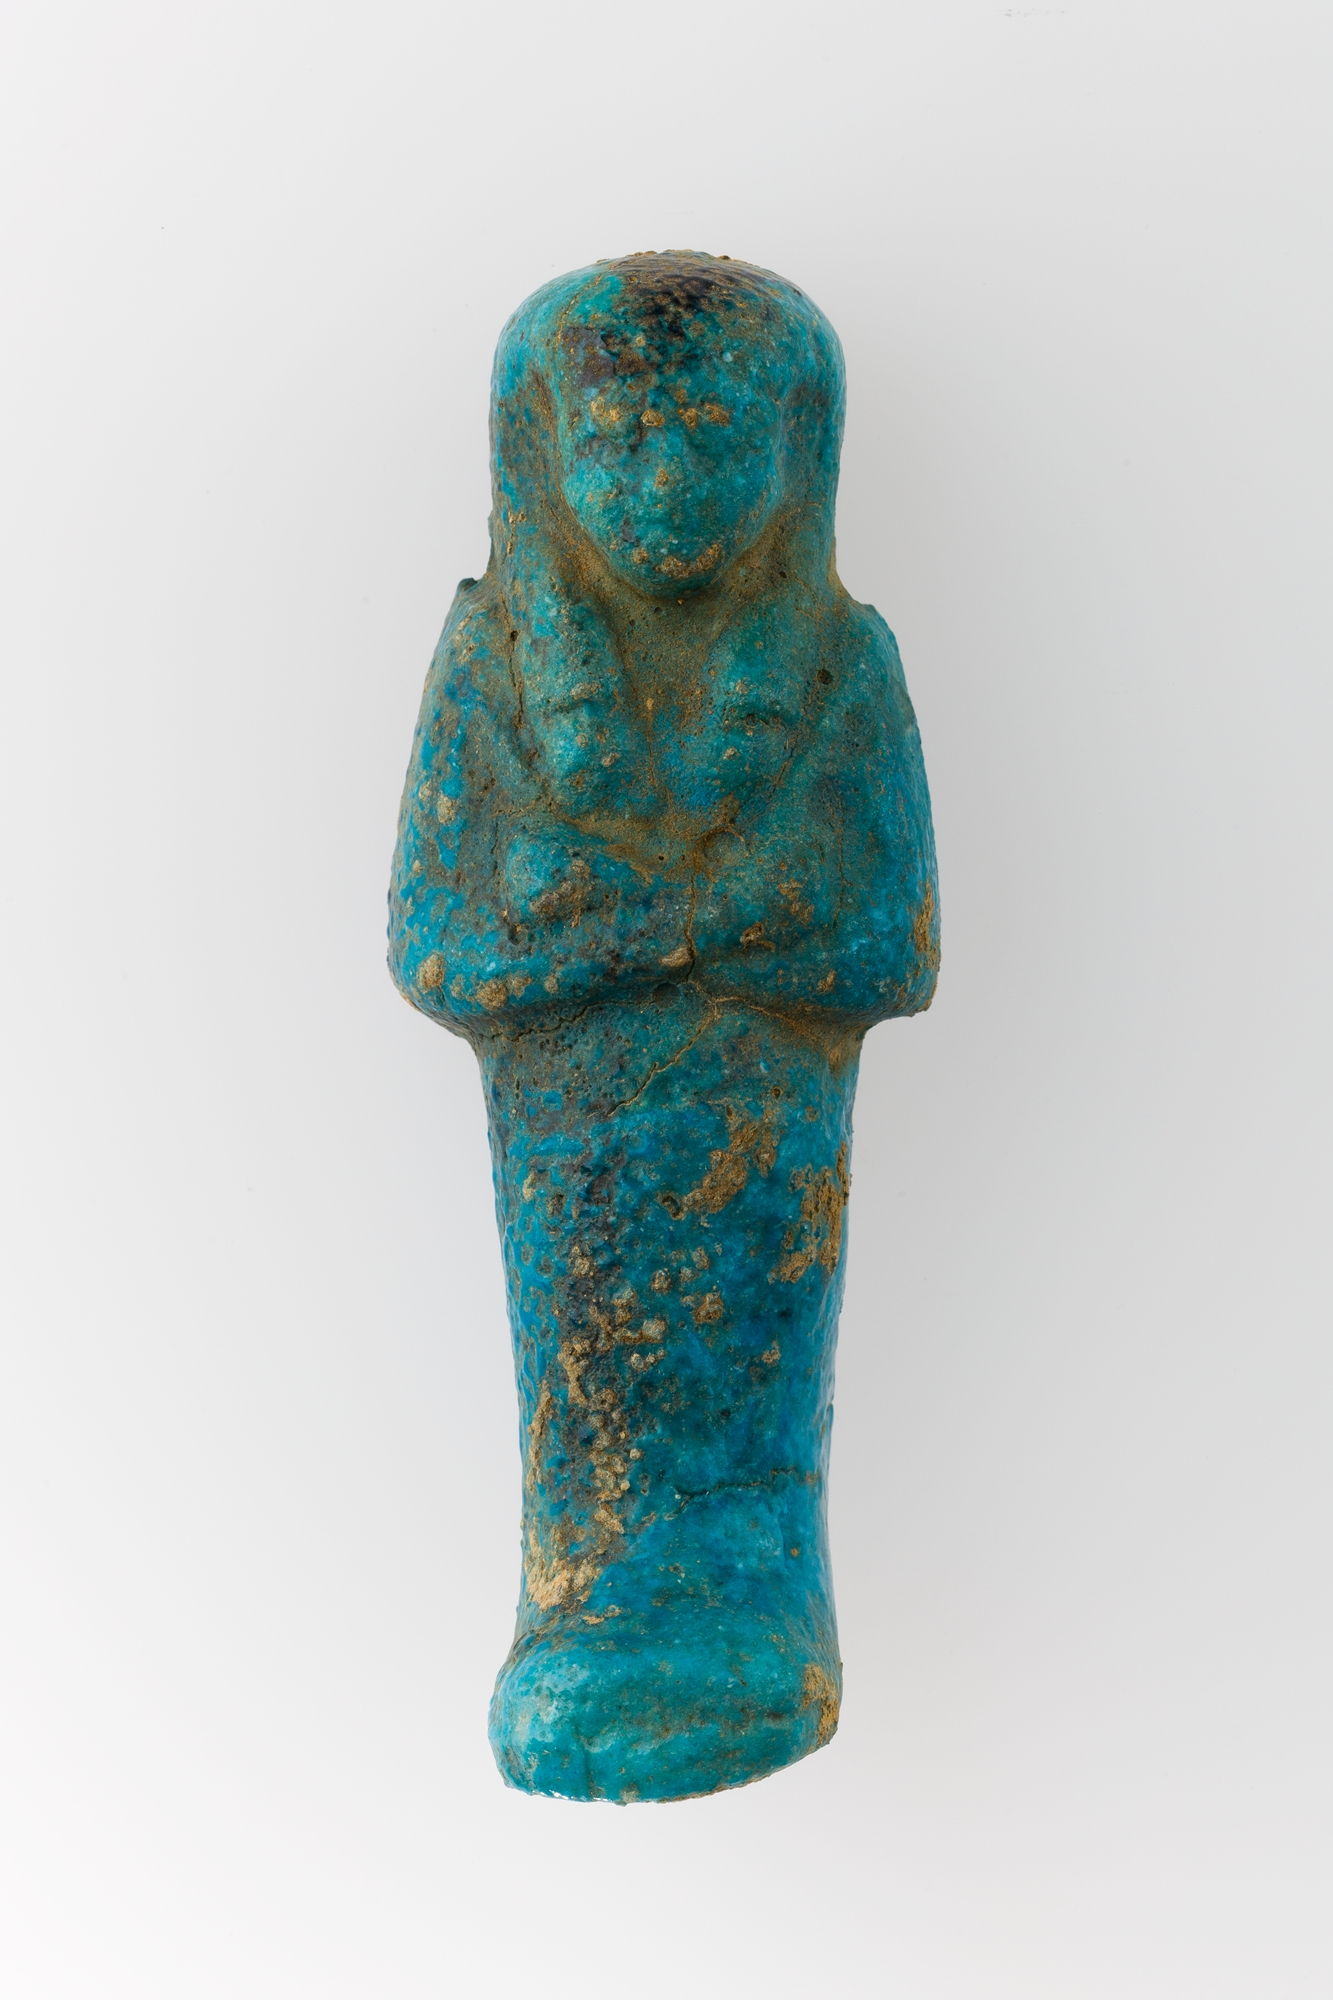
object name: shabti, henettawy c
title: Worker Shabti of Henettawy (C), Daughter of Isetemkheb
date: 990-970 BCE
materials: faience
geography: egypt